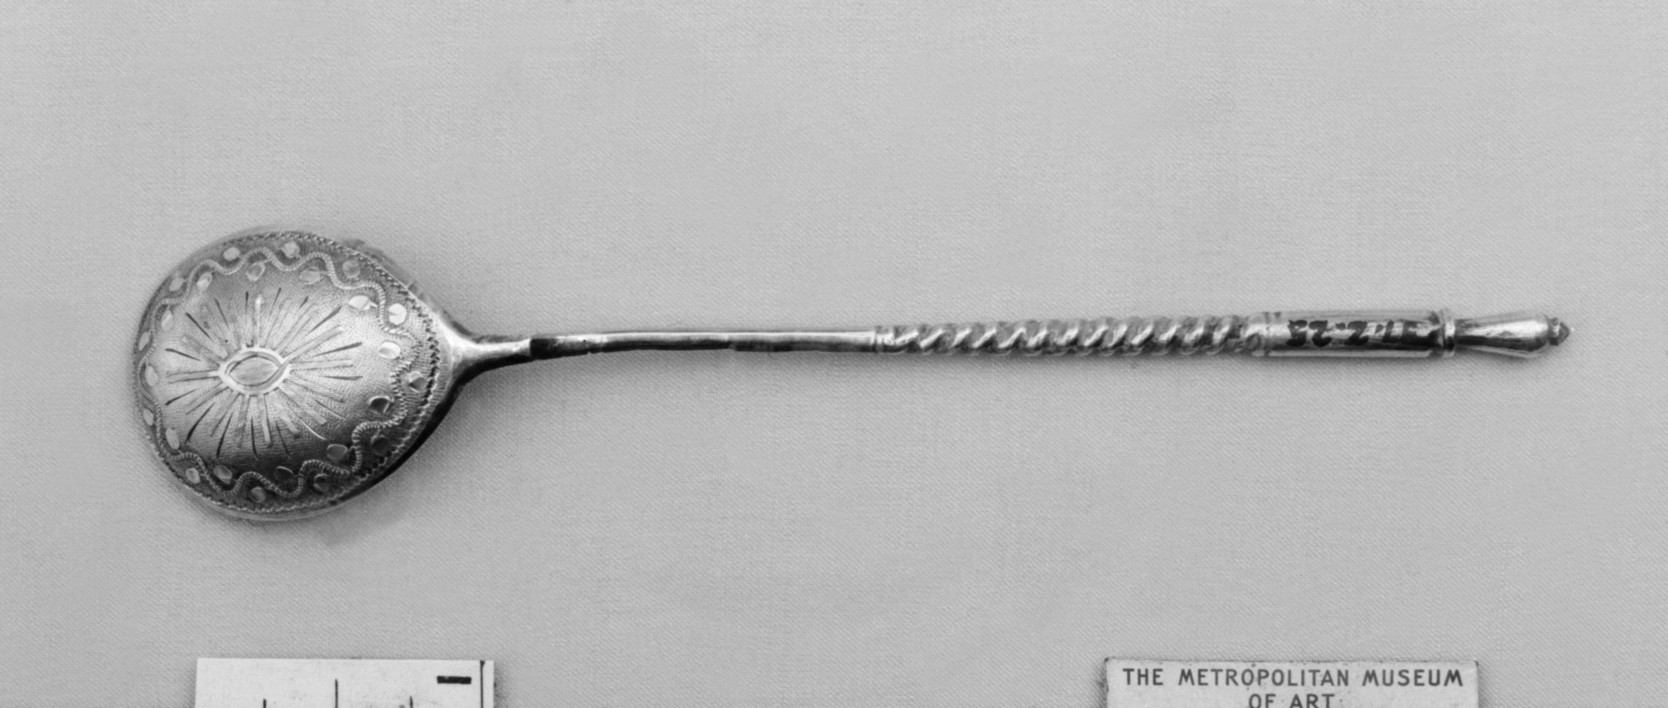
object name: coffee or egg spoon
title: Coffee spoon (?) or egg spoon (?)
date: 1887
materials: gilt, silver